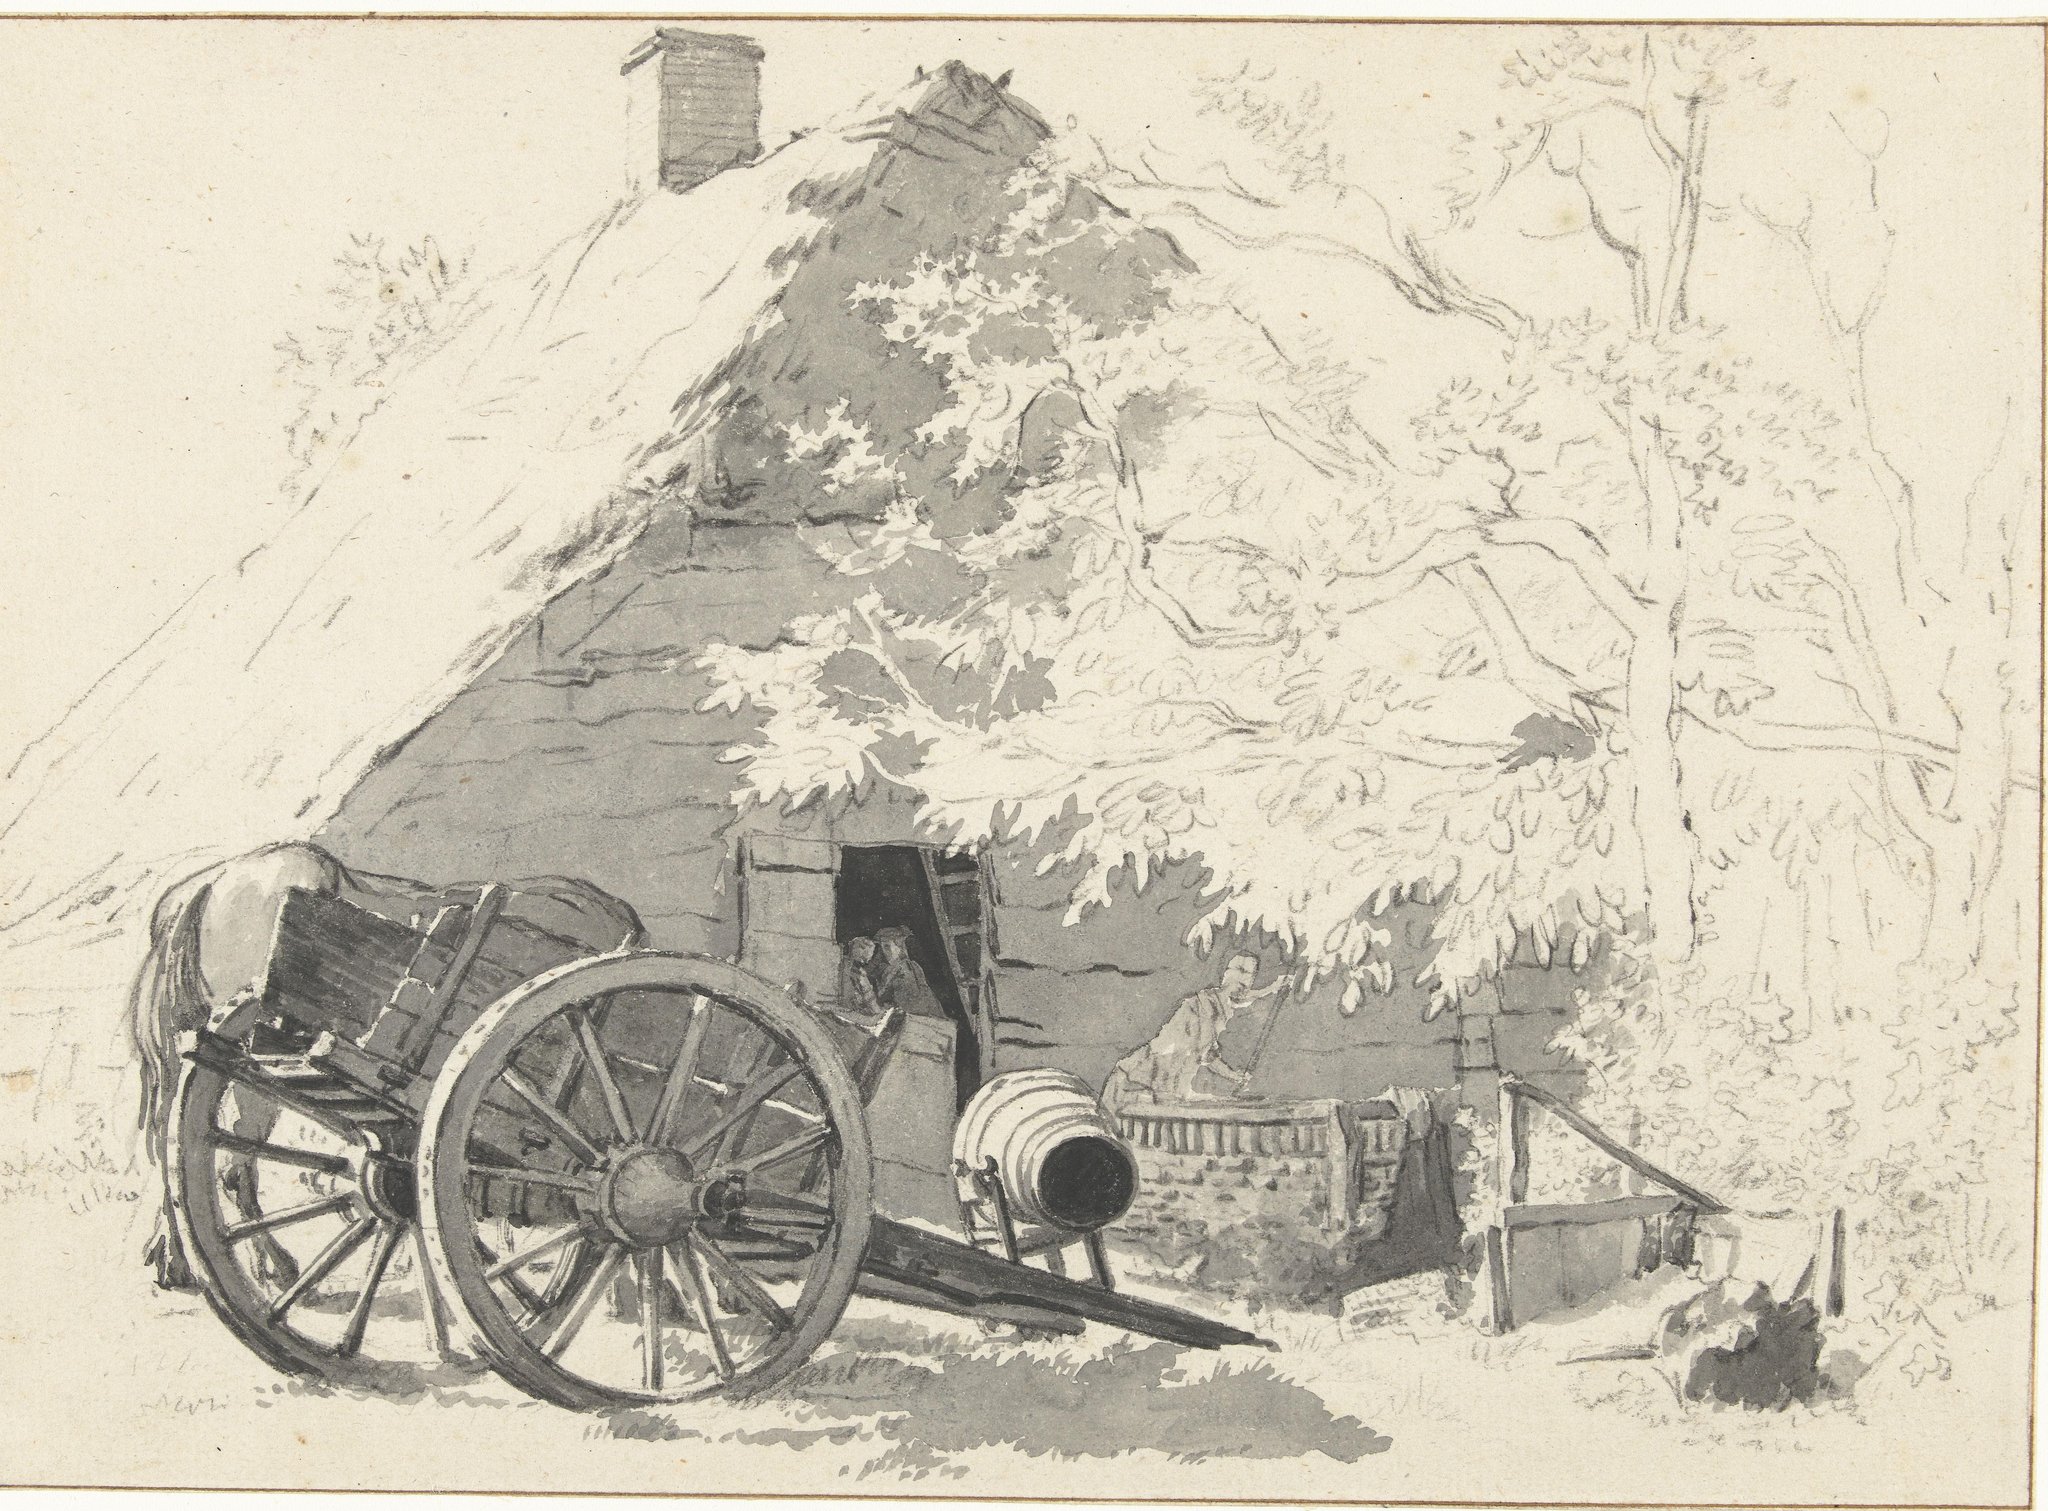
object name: drawing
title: Melkkar met paard voor een boerderij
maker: jacob ernst marcus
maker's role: draughtsman, print maker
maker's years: 1774-1826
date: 1784-1826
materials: chalk, paper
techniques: brush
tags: farm or solitary house in landscape